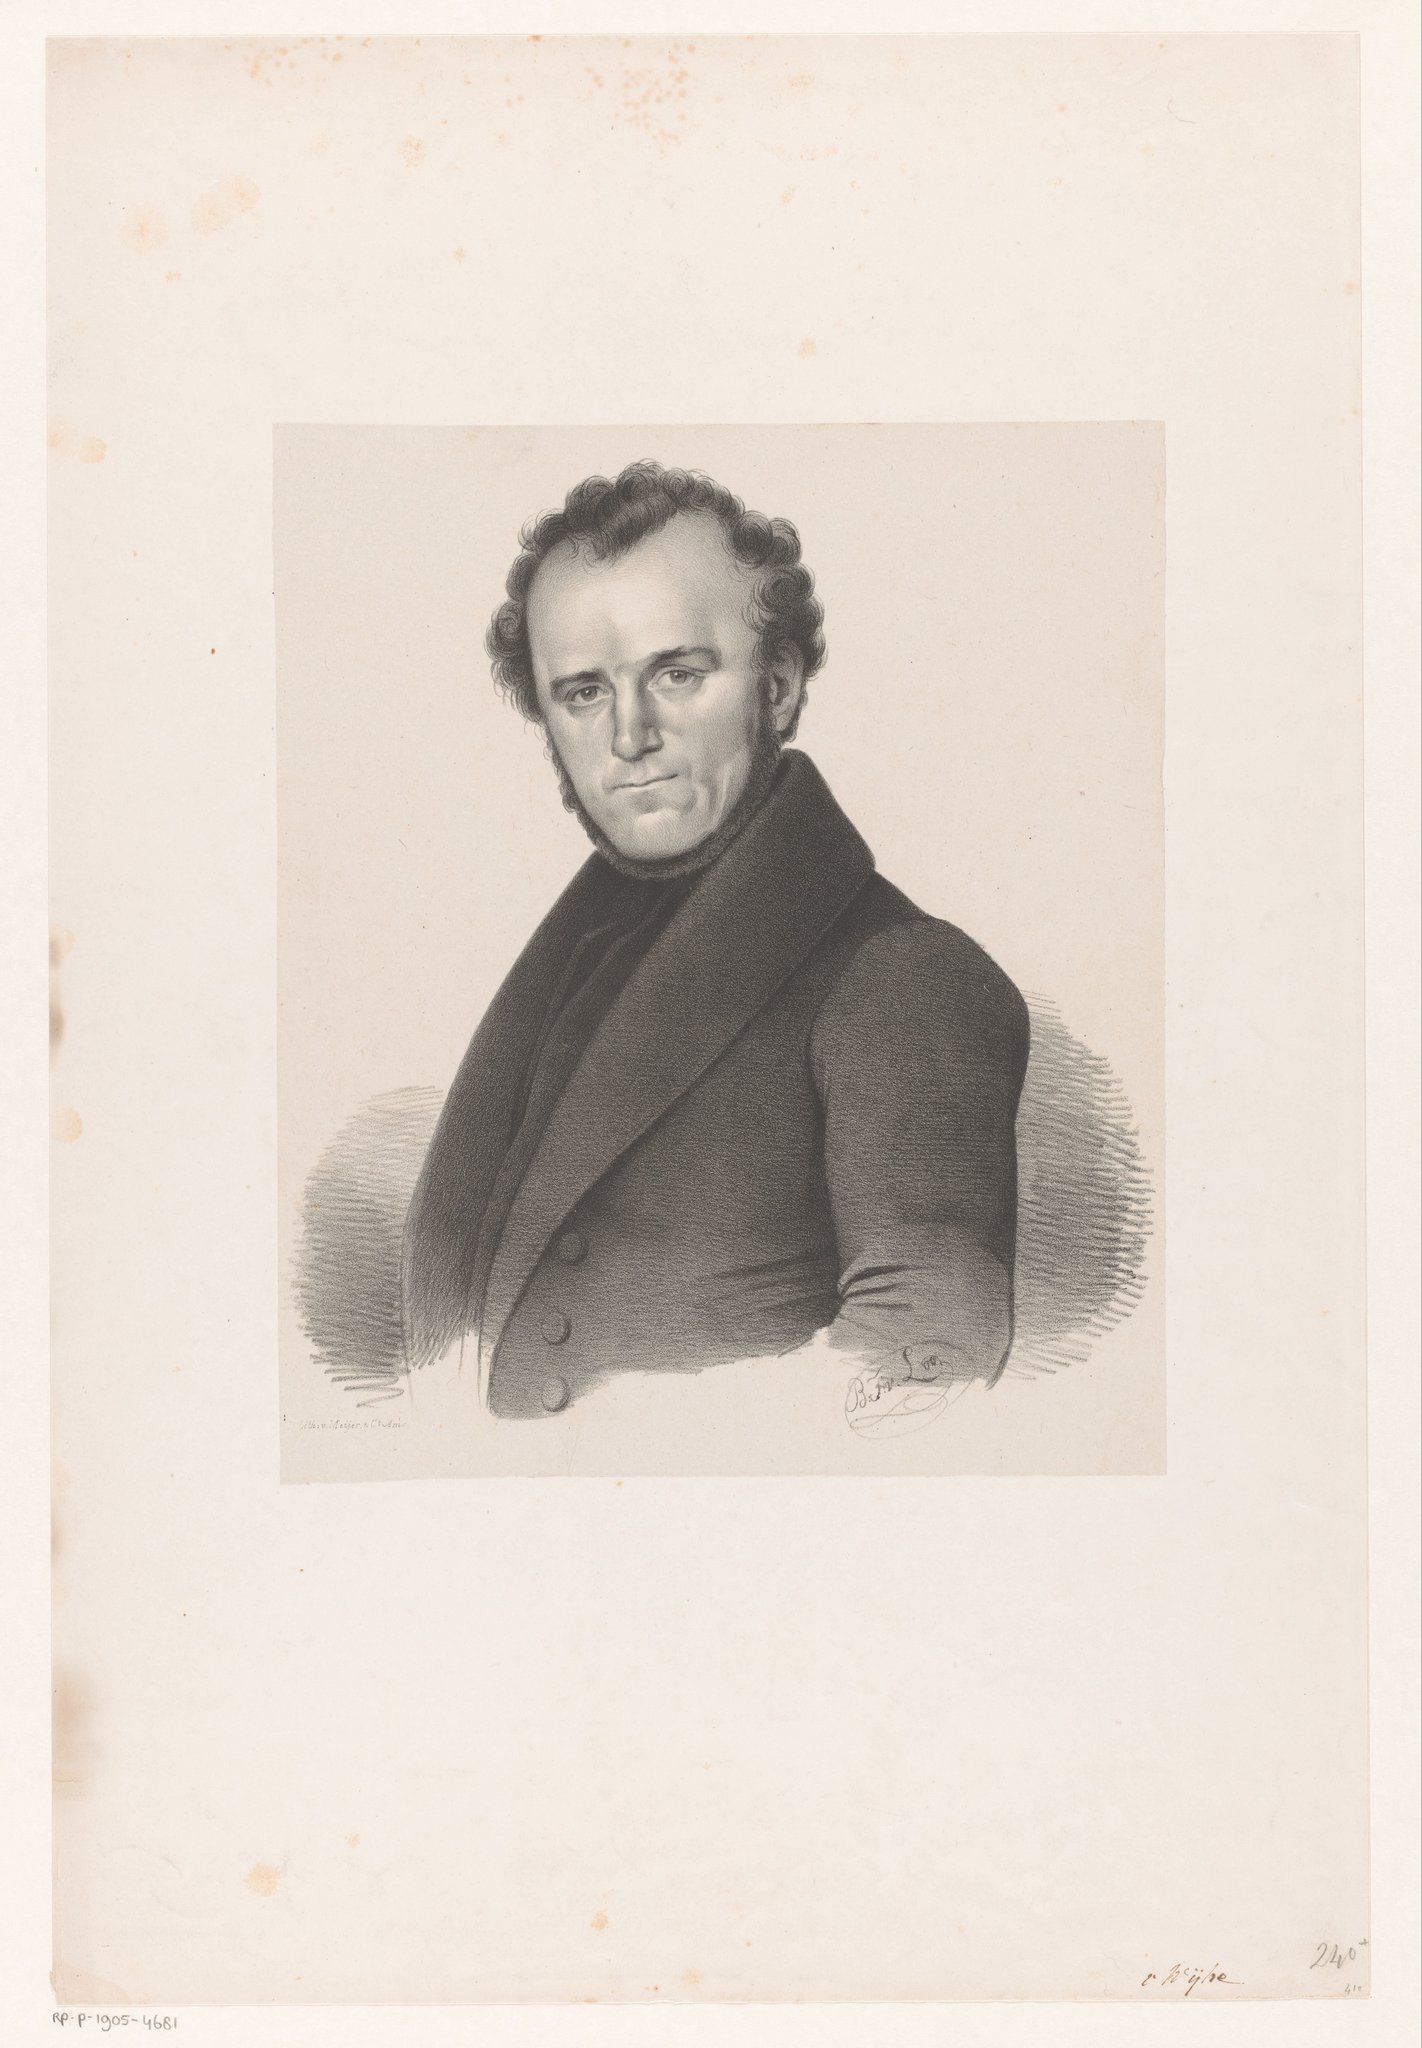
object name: print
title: Portret van een onbekende man, mogelijk de heer Van Wijhe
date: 1826-1892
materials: paper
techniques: lithograph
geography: amsterdam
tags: historical persons (+ (full) bust portrait)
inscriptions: collector's mark: Lugt 2228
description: De naam Van Wijhe staat vermeld op het opzetblad en in het inventarisboek.